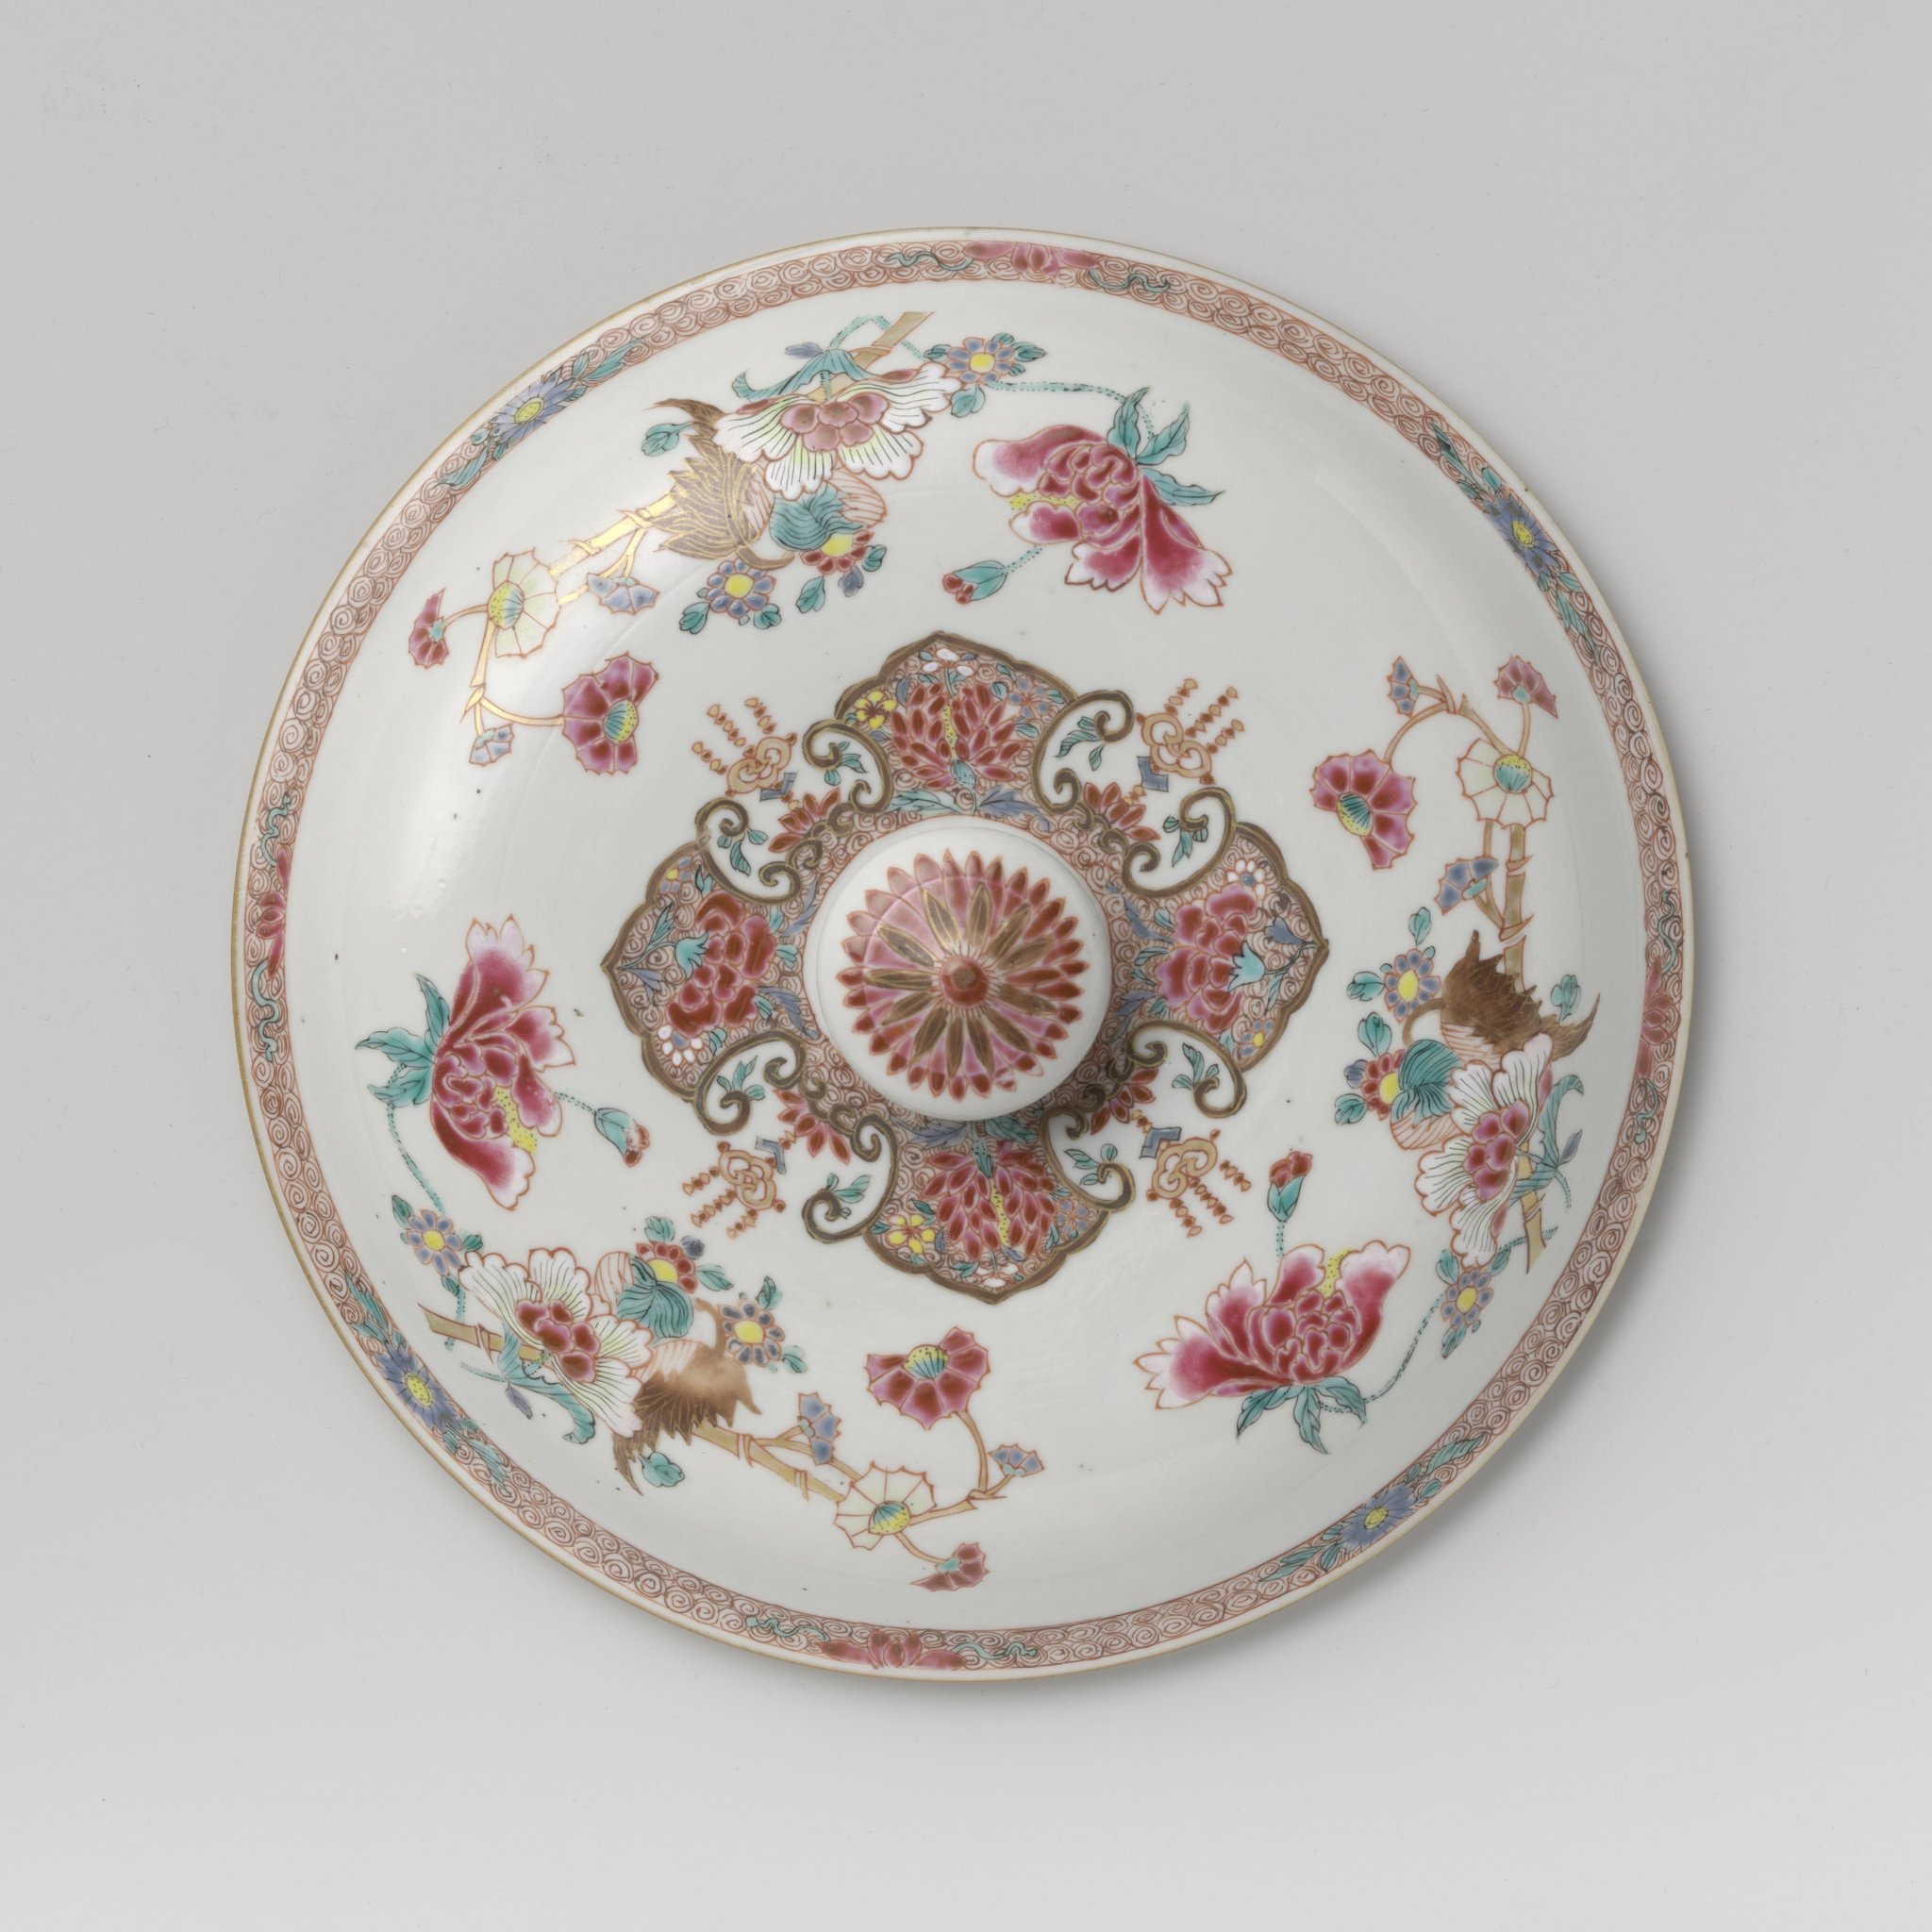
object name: lid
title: Covered tureen with groups of flowers and ornamental border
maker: Anonymous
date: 1800-1899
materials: glaze, gold, paint, porcelain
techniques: firing, gilding, turning, vitrification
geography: china